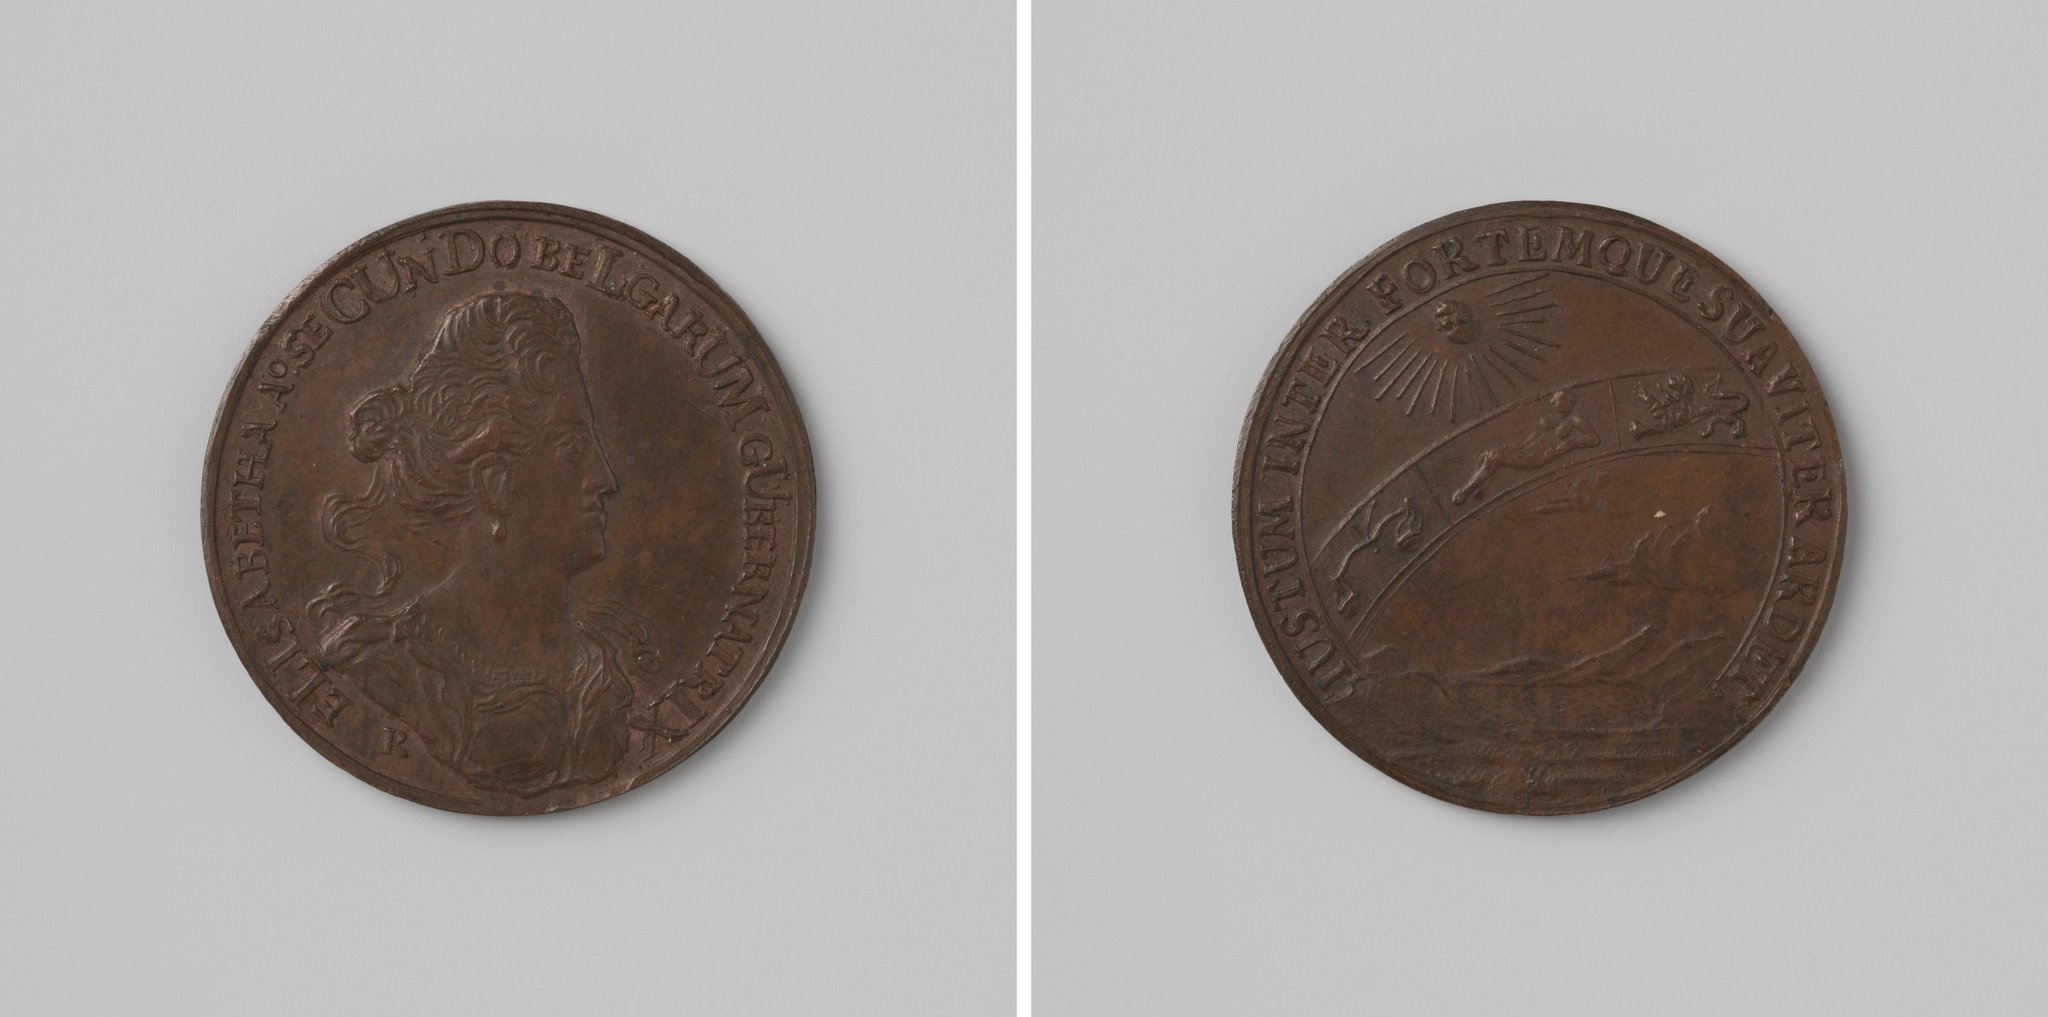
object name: new year medal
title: Maria Elisabeth van Oostenrijk, sinds twee jaar landvoogdes der zuidelijke Nederlanden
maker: philippe roëttiers (iii)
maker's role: medailleur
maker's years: 1686-1873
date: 1727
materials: bronze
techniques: striking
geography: paris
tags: maria elisabeth (aartshertogin van oostenrijk)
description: Bronzen penning. Voorzijde: borststuk vrouw binnen omschrift. Keerzijde: zon bestraalt bergachtig landschap, daarboven gedeelte van dierenriem binnen omschrift